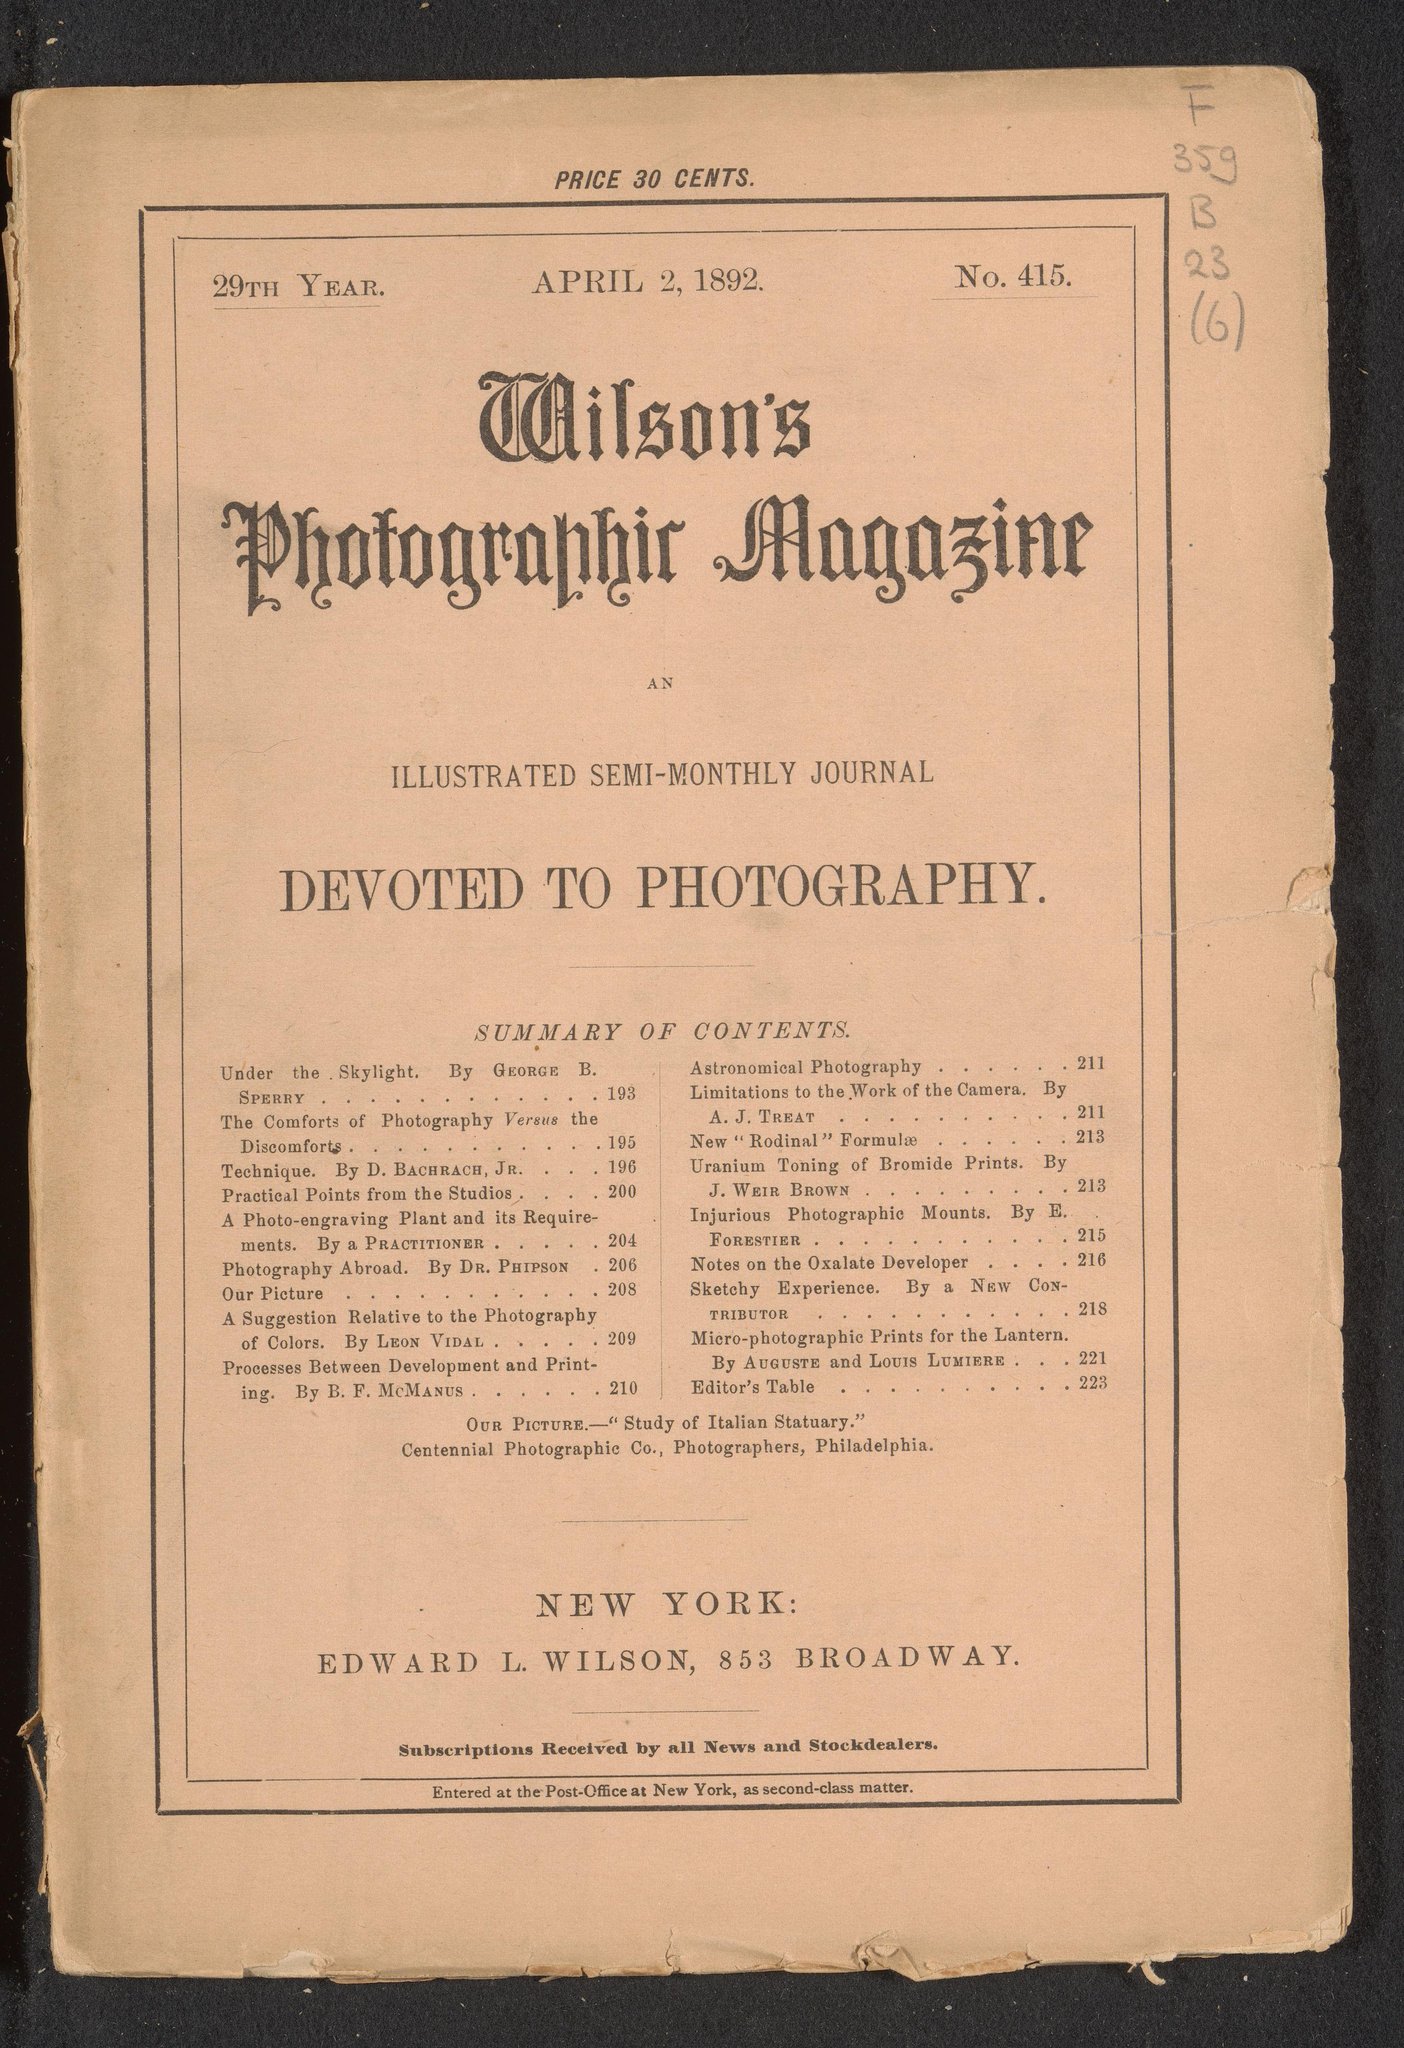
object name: magazine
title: Wilson's photographic magazine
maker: edward livingston wilson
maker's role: publisher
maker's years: 1838-1903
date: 1892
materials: paper, photographic support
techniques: albumen print, printing, engraving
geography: new york city